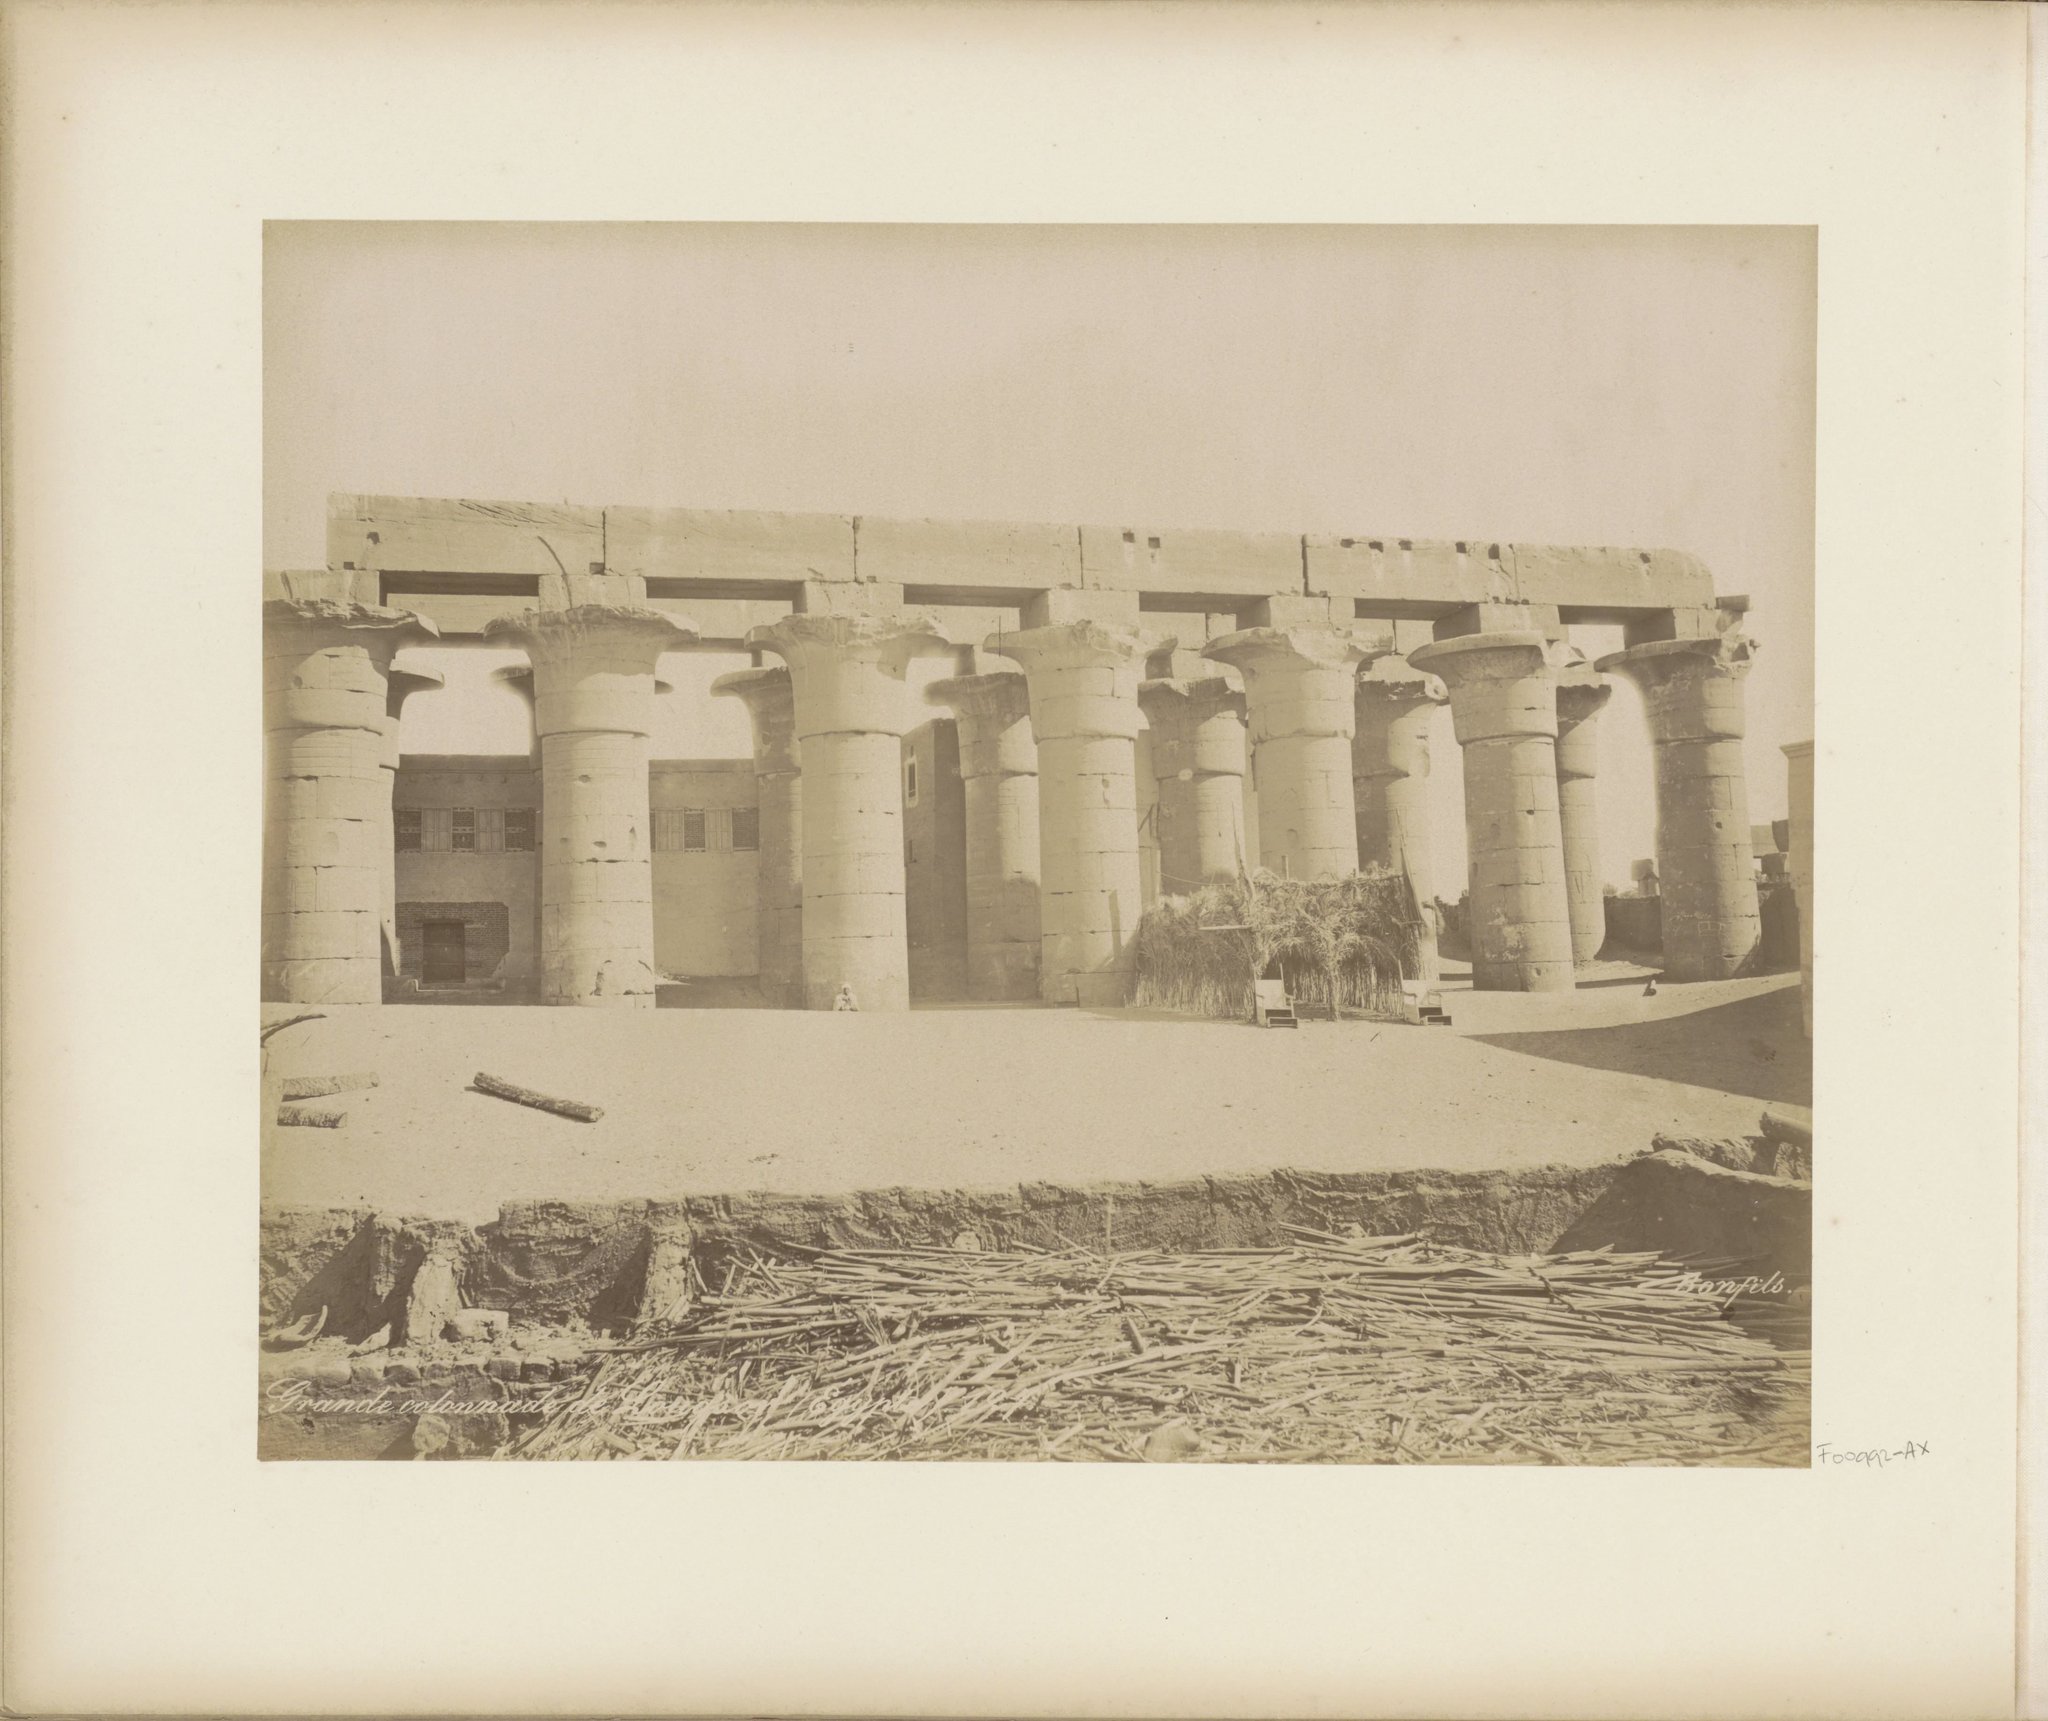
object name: photograph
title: Grande colonnade de Louqsor (Égypte)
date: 1870-1898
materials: cardboard, paper, photographic support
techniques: albumen print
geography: luxor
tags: colonnade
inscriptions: negative number: ‘127’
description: Onderdeel van Reisalbum met 80 foto's van Egypte.